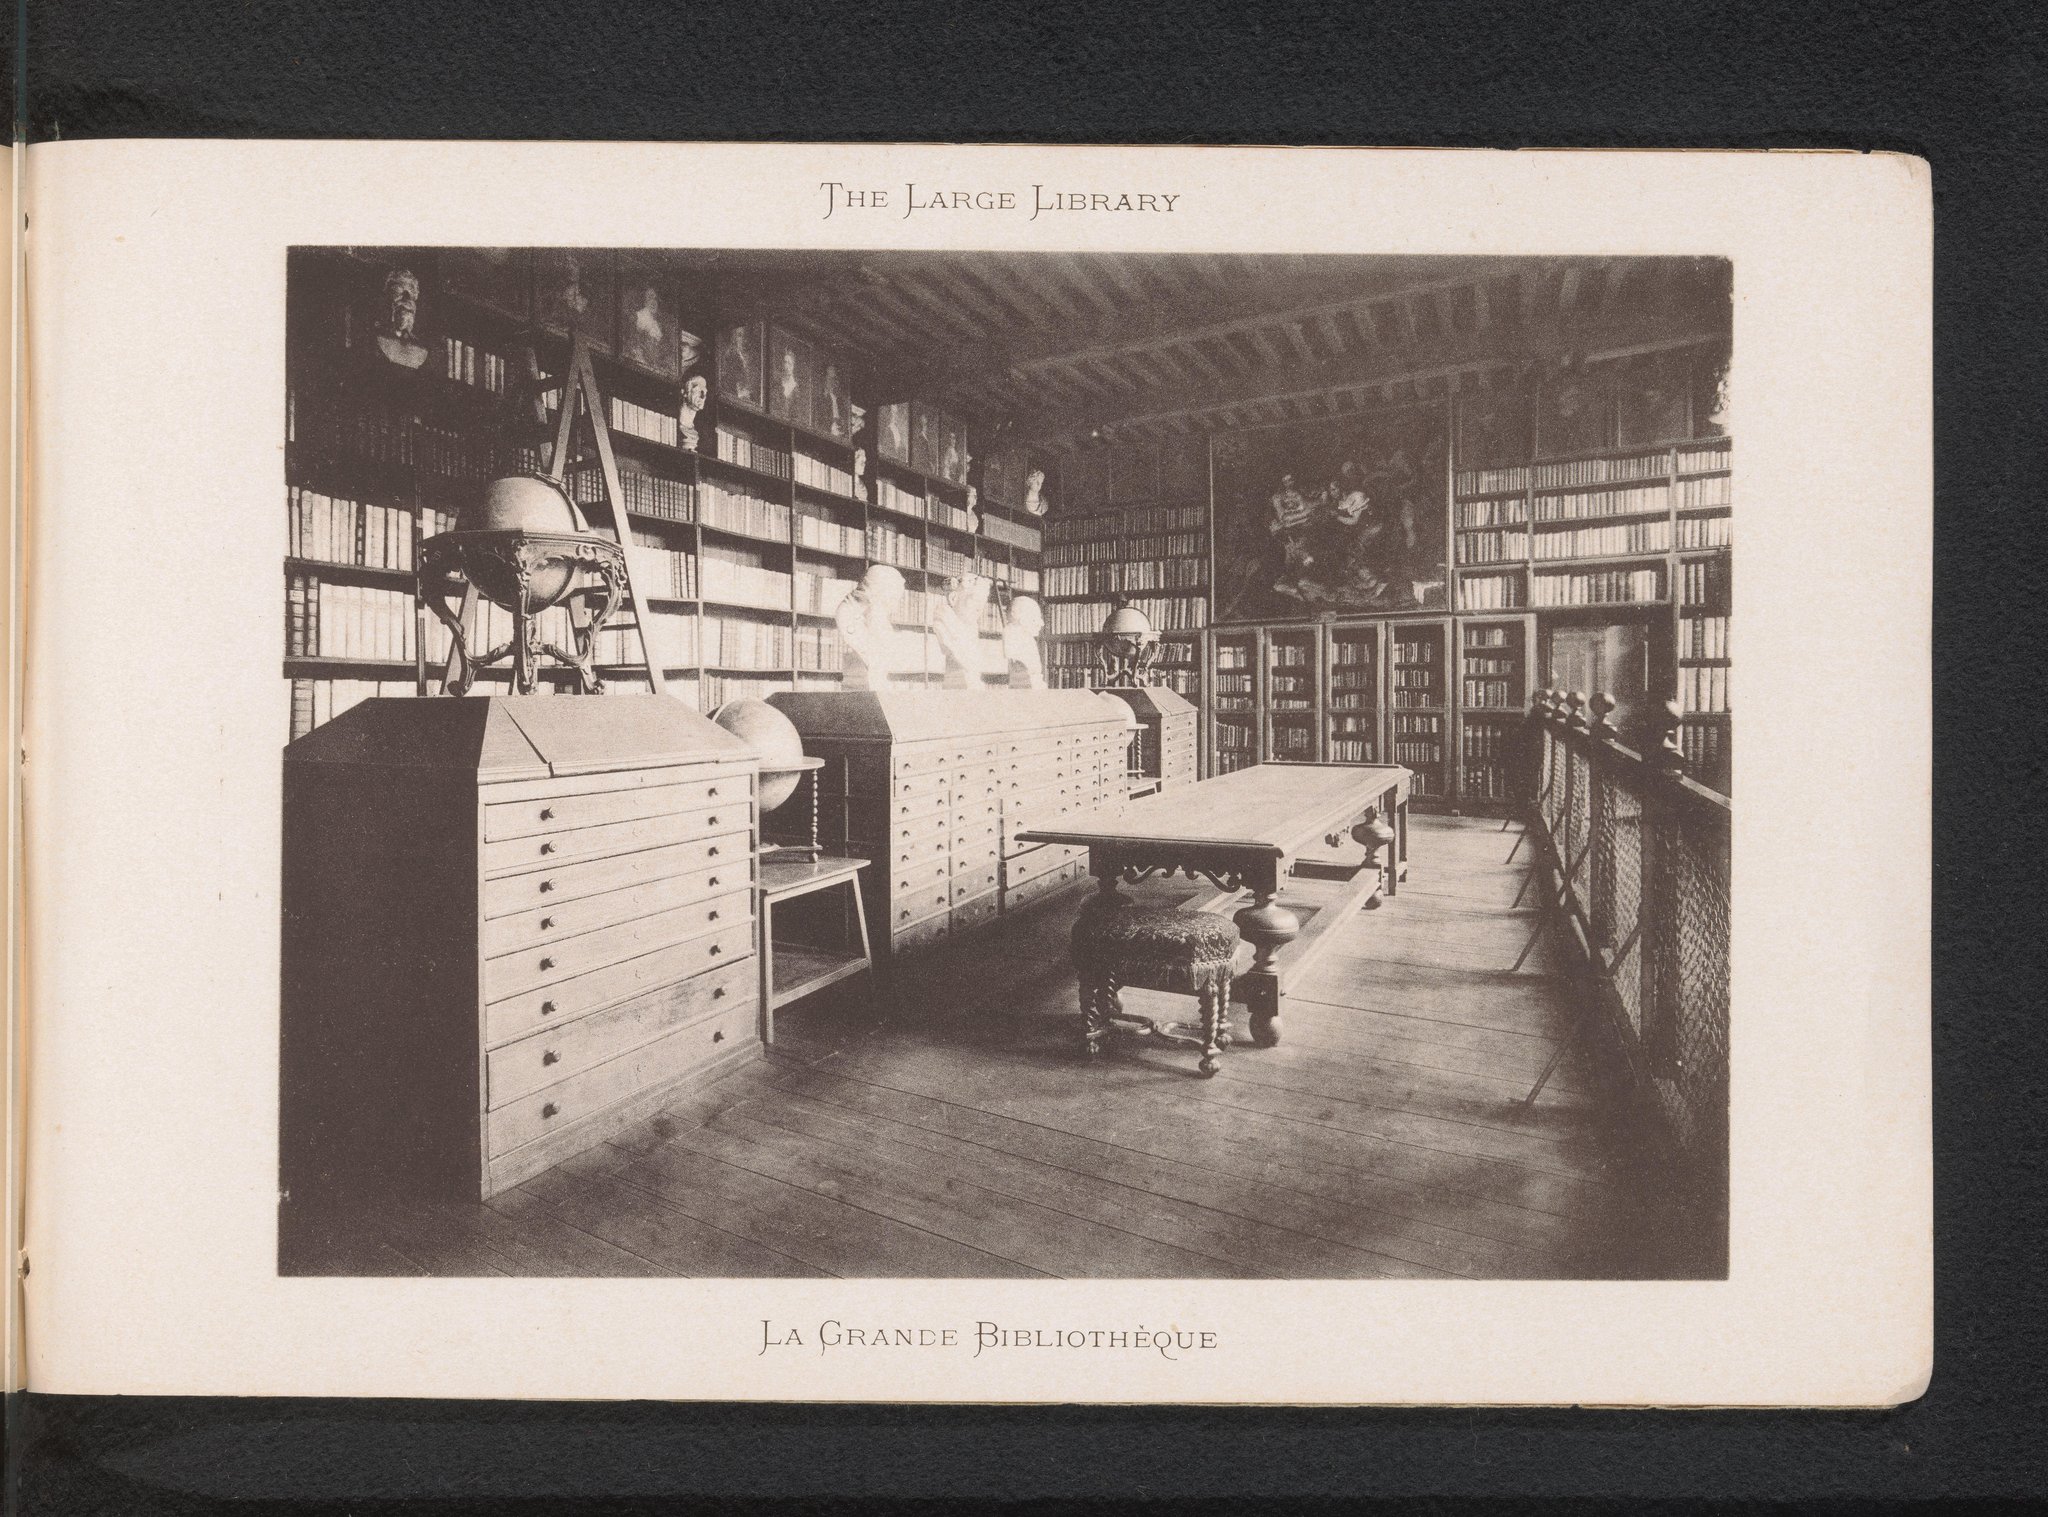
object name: page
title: Grote bibliotheek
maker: Anonymous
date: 1892-1897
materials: paper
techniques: photograph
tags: study; 'studiolo'; library